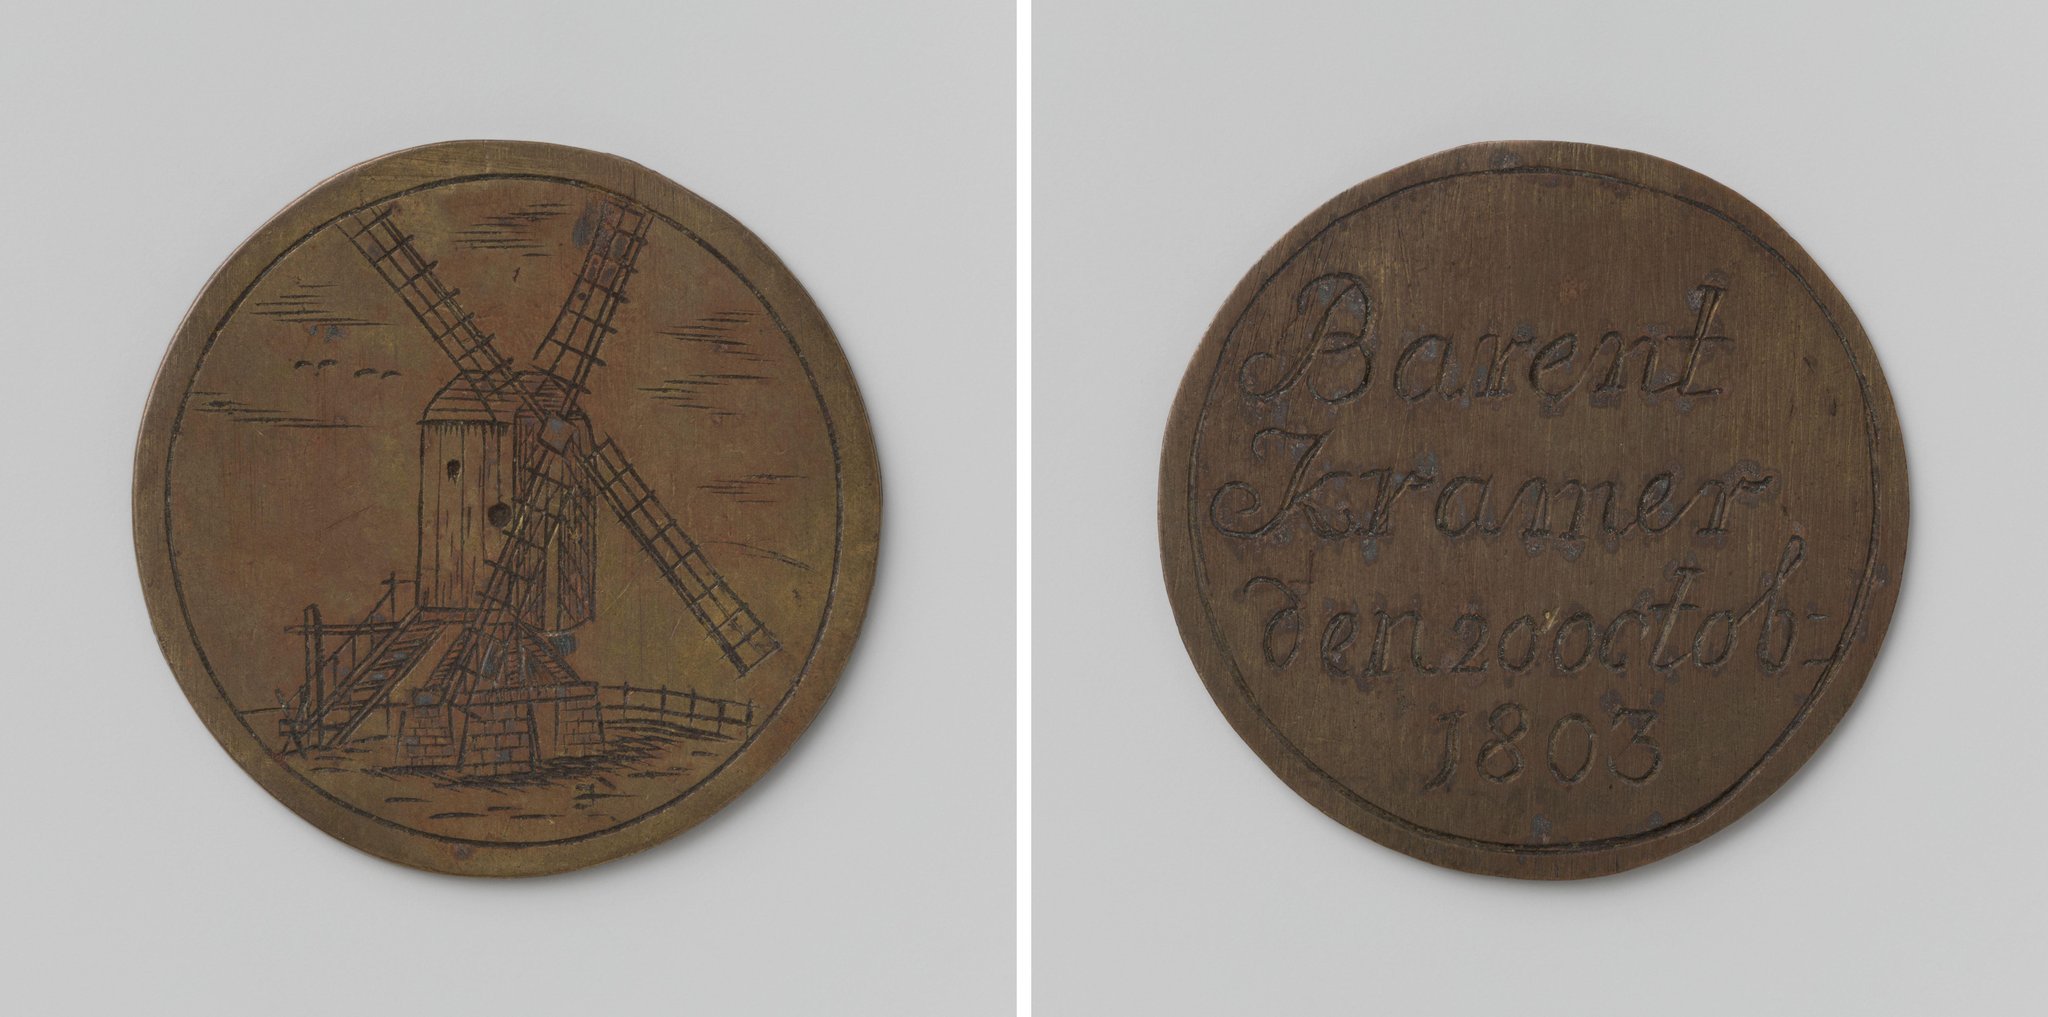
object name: medal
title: Korenmolenaarsgilde van Amsterdam, gildepenning van Barent Kramer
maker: Anonymous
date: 1803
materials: brass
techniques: engraving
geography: amsterdam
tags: barent kramer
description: Messing penning. Voorzijde: korenmolen. Keerzijde: opschrift